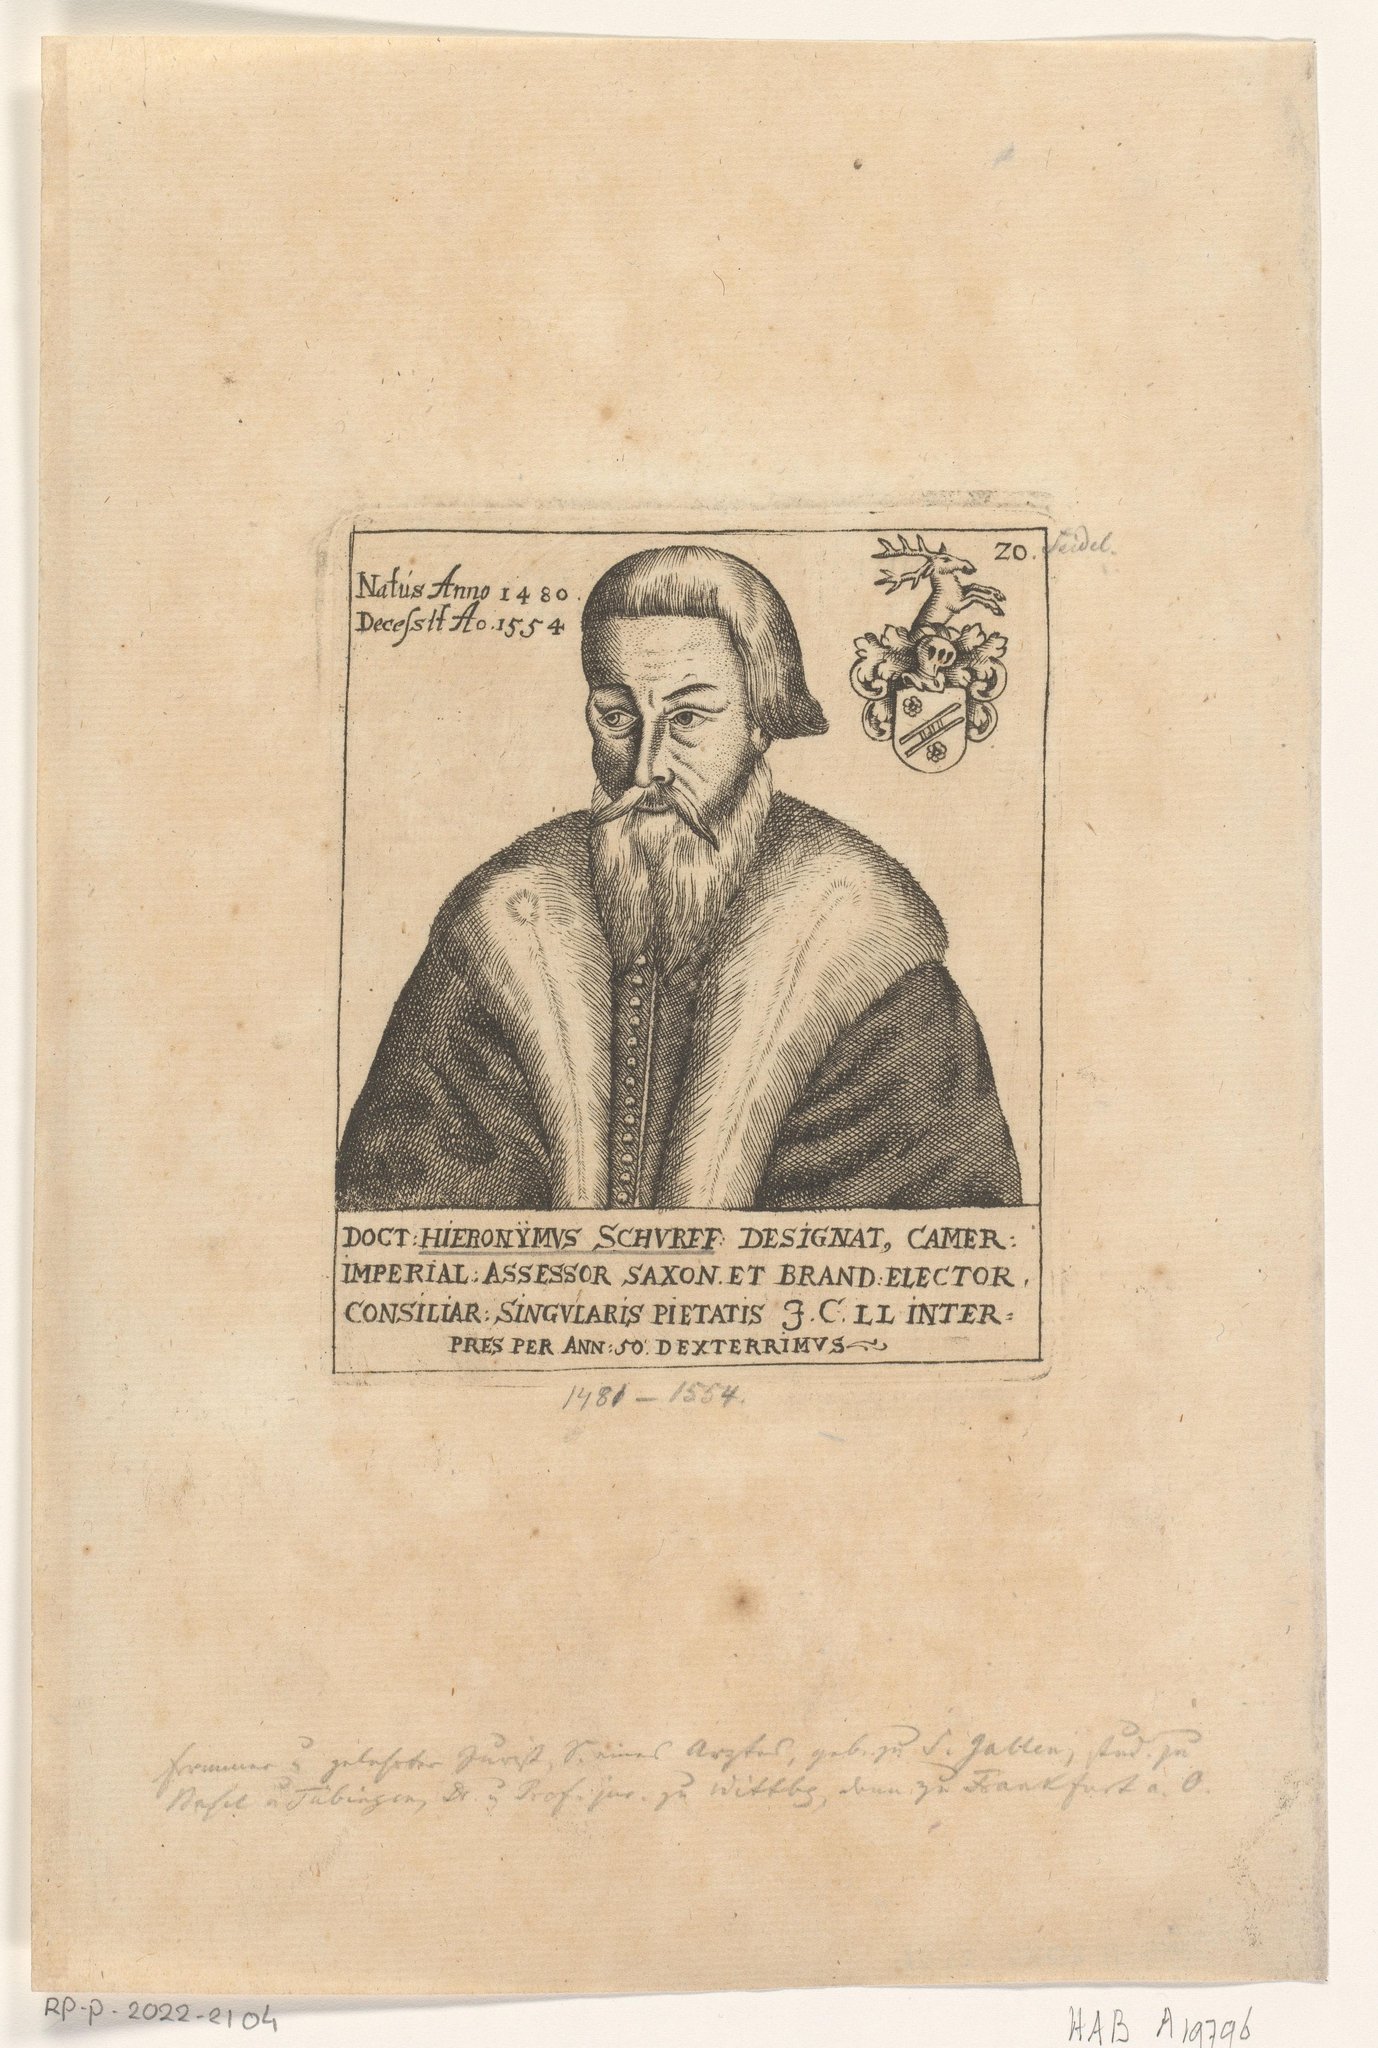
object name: print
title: Portret van Hieronymus Schurff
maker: Anonymous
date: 1751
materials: paper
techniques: engraving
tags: historical persons, lawyer, attorney at law, armorial bearing, heraldry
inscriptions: inscription: ‘[...] Jurist (...) Frankfurt a.O.’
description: De prent is uitgegeven als onderdeel van een serie. Later is de prent mogelijk ook als boekillustratie gebruikt in: Küster, Georg Gottfried. Martin Friedrich Seidels Bilder-Sammlung in welcher hundert, gröstentheils in der Mark Brandenburg (…). Berlijn: Buchladen bey der Real-Schule, 1751. Het is onduidelijk tot welke uitgave de huidige prent behoort.